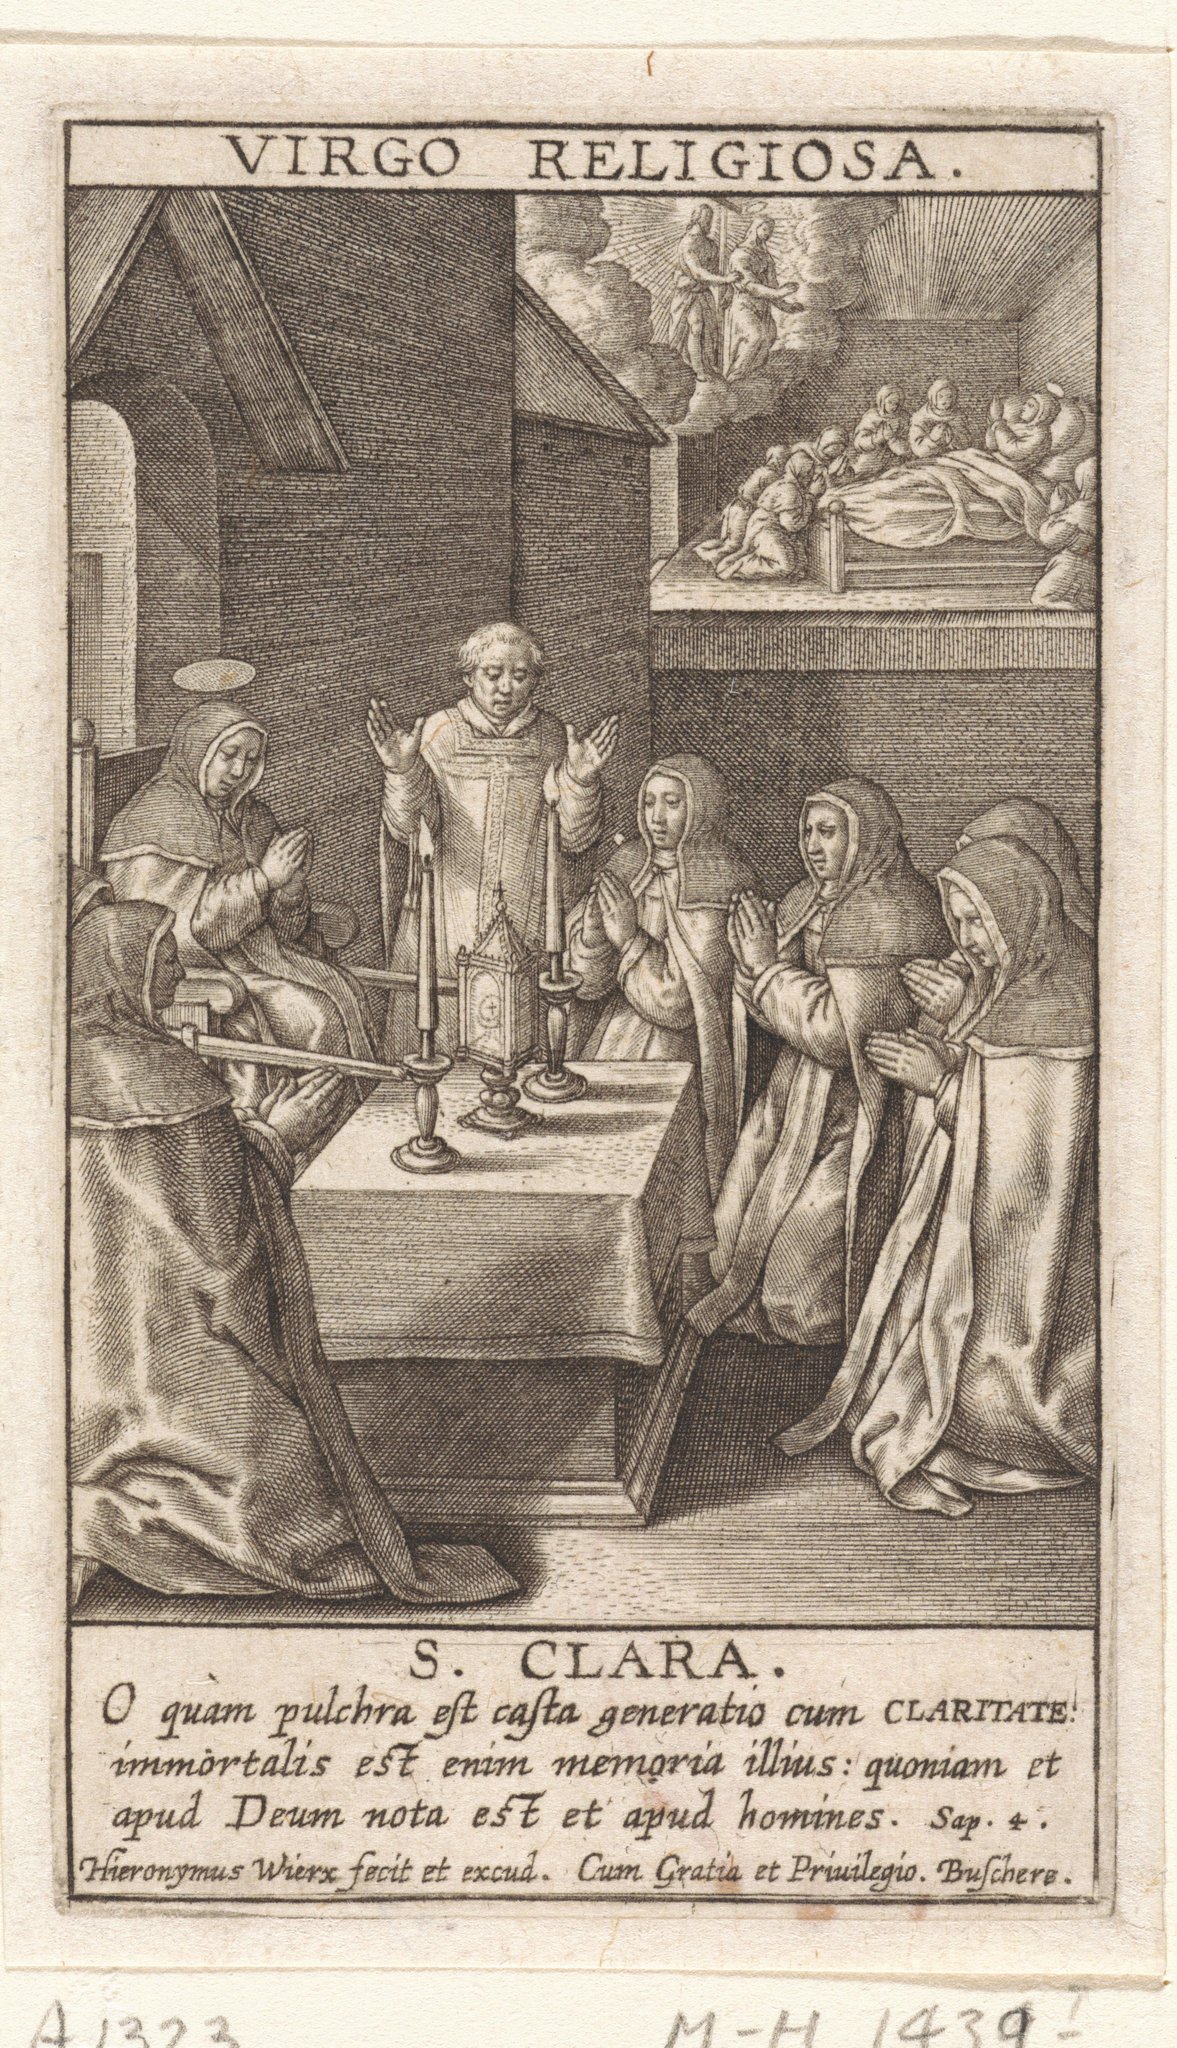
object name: print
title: H. Clara van Assisi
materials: paper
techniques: engraving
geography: antwerp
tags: personal devotion of st. clare, death-bed of st. clare: nuns, female martyrs, and the pope with cardinals may be present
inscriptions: collector's mark: Lugt 240, number: ‘47’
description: De heilige Clara, gekleed in het habijt van de franciscaner orde, in aanbidding voor de monstrans met de hostie tijdens de mis. Ze is vergezeld door een priester en zusters van haar orde. Op de achtergrond de dood van Clara. Christus en Maria verschijnen als een visioen boven haar bed. In de marge een drieregelig Bijbelcitaat uit Wijsh. 4 in het Latijn.